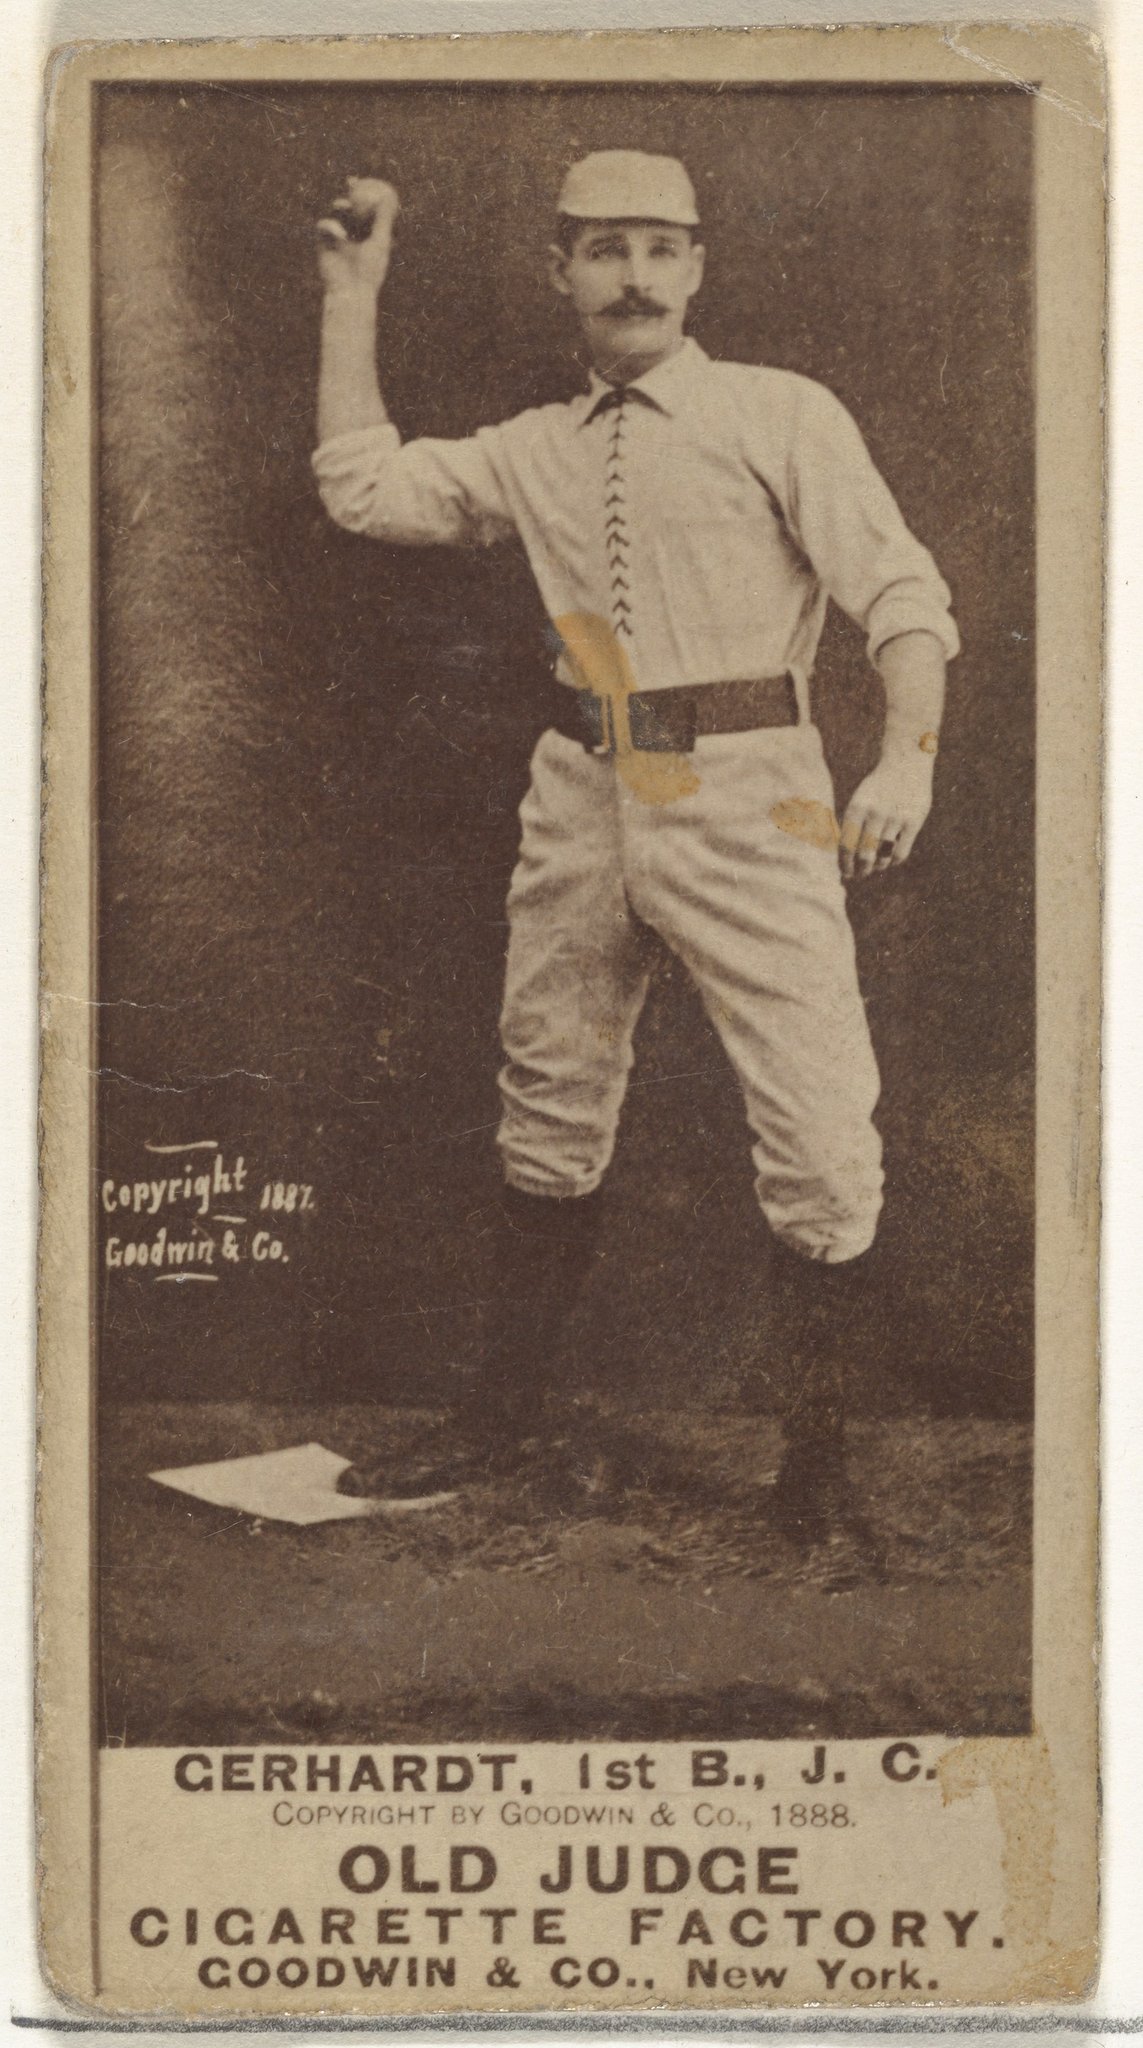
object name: baseball card, photograph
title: John Joseph "Joe" Gerhardt, 1st Base, Jersey City Skeeters, from the Old Judge series (N172) for Old Judge Cigarettes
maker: goodwin & company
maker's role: publisher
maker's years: 1850-1950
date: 1888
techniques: albumen silver print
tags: men,portraits,baseball,athletes